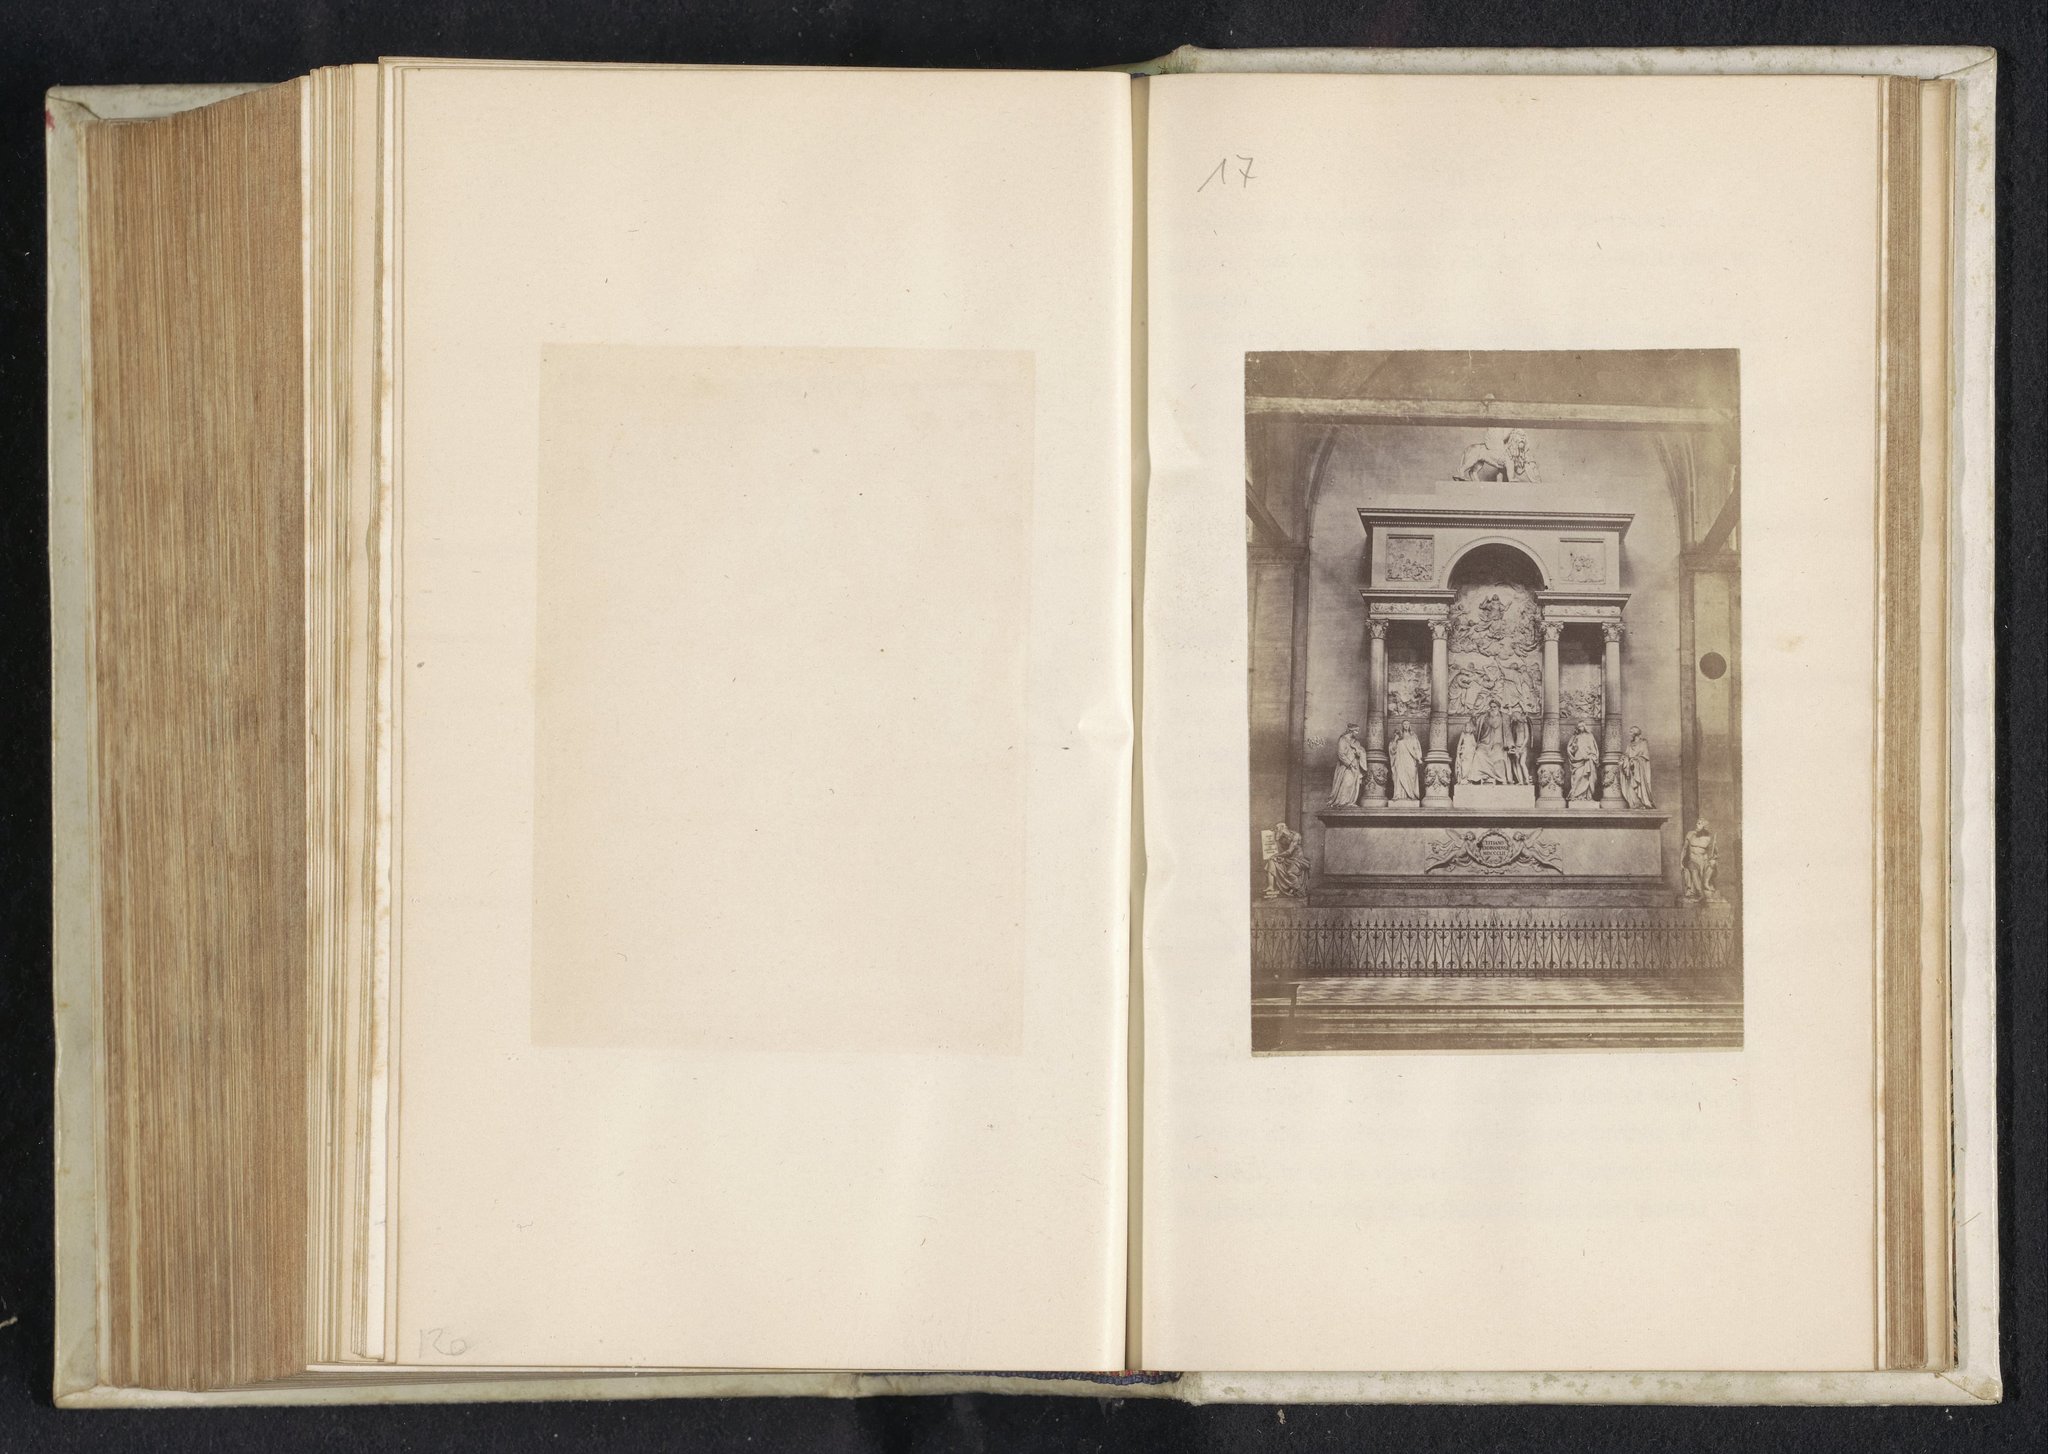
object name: page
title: Grafmonument van Titiaan in de Basilica di Santa Maria Gloriosa dei Frari te Venetië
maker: Anonymous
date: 1850-1860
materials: photographic support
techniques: albumen print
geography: basilica di santa maria gloriosa dei frari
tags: interior of church, grave-building, monumental tomb